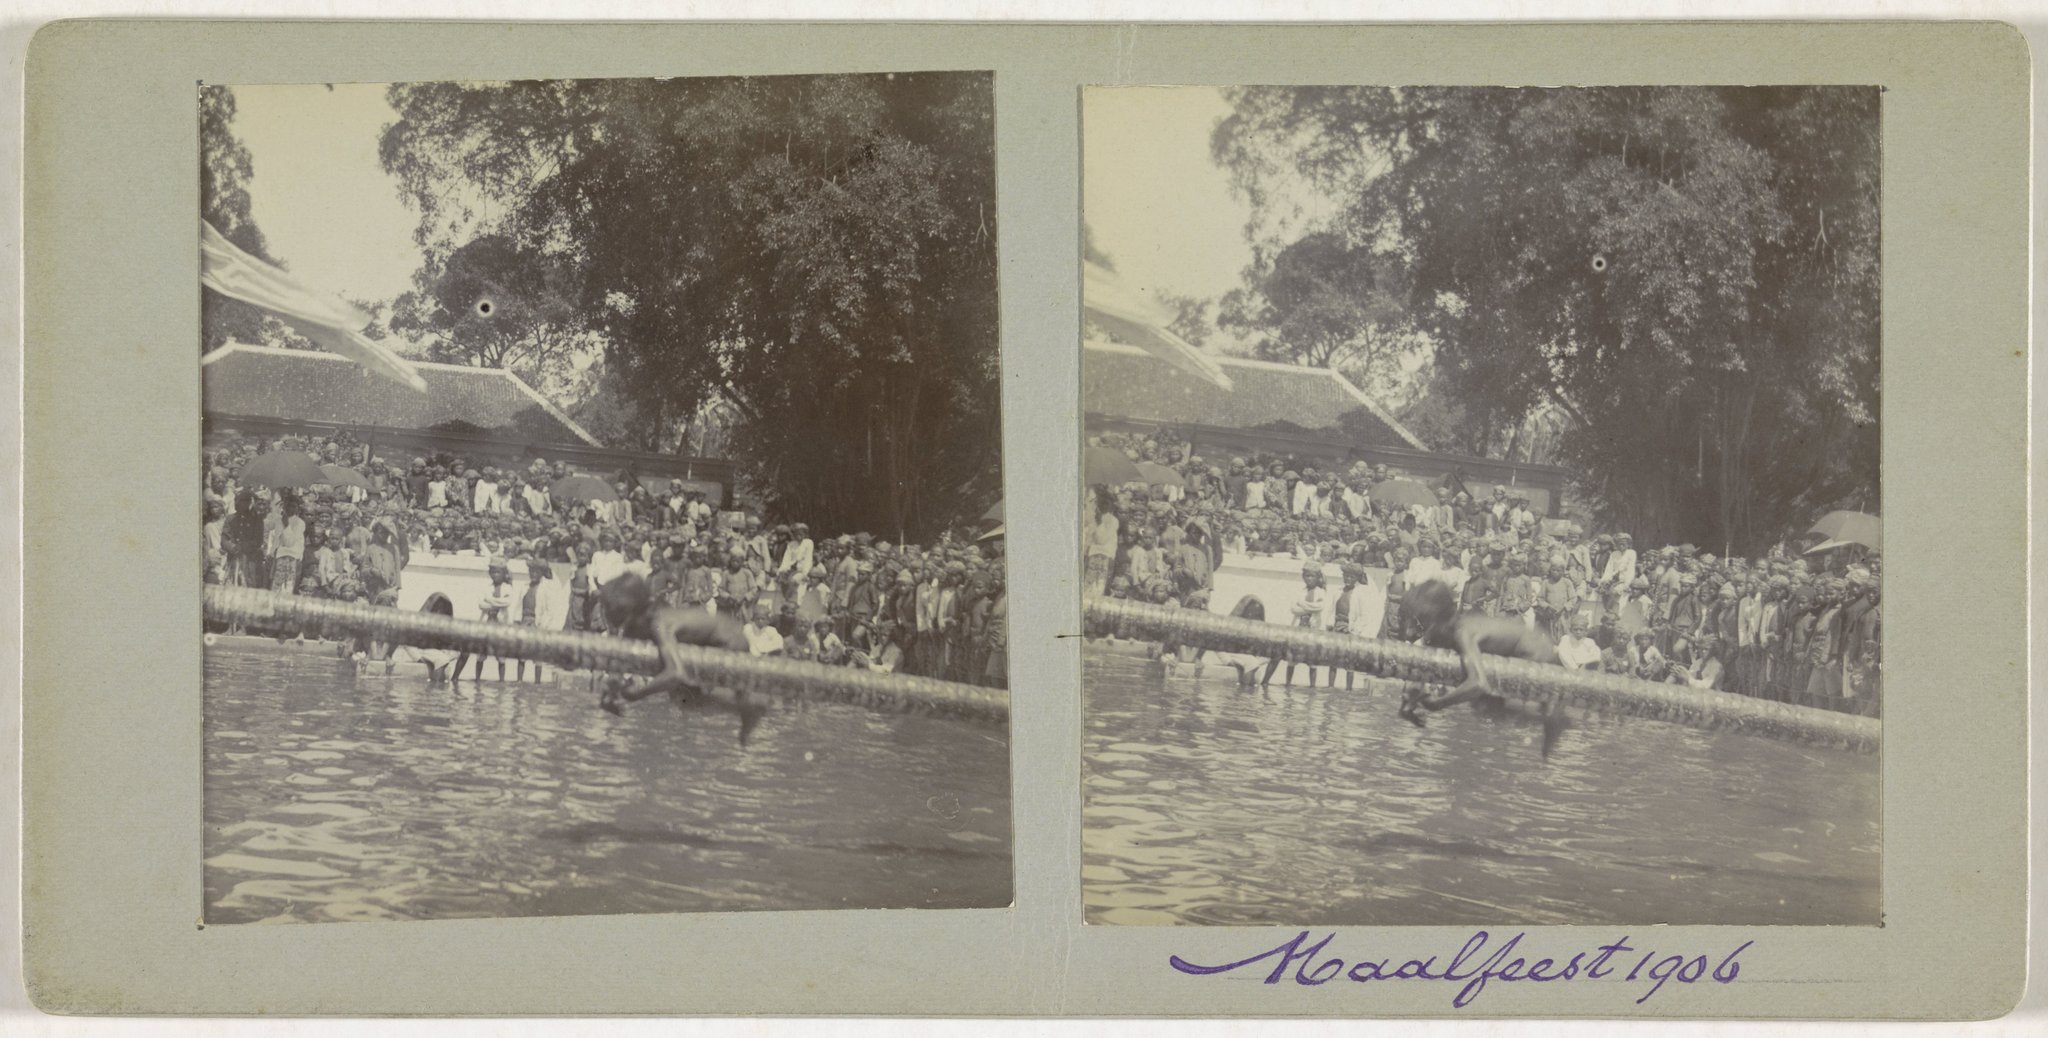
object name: stereograph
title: Jongen kruipt over horizontale paal tijdens het Maalfeest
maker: Anonymous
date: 1906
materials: cardboard, paper, photographic support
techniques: albumen print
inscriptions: title: ‘Maalfeest 1906’